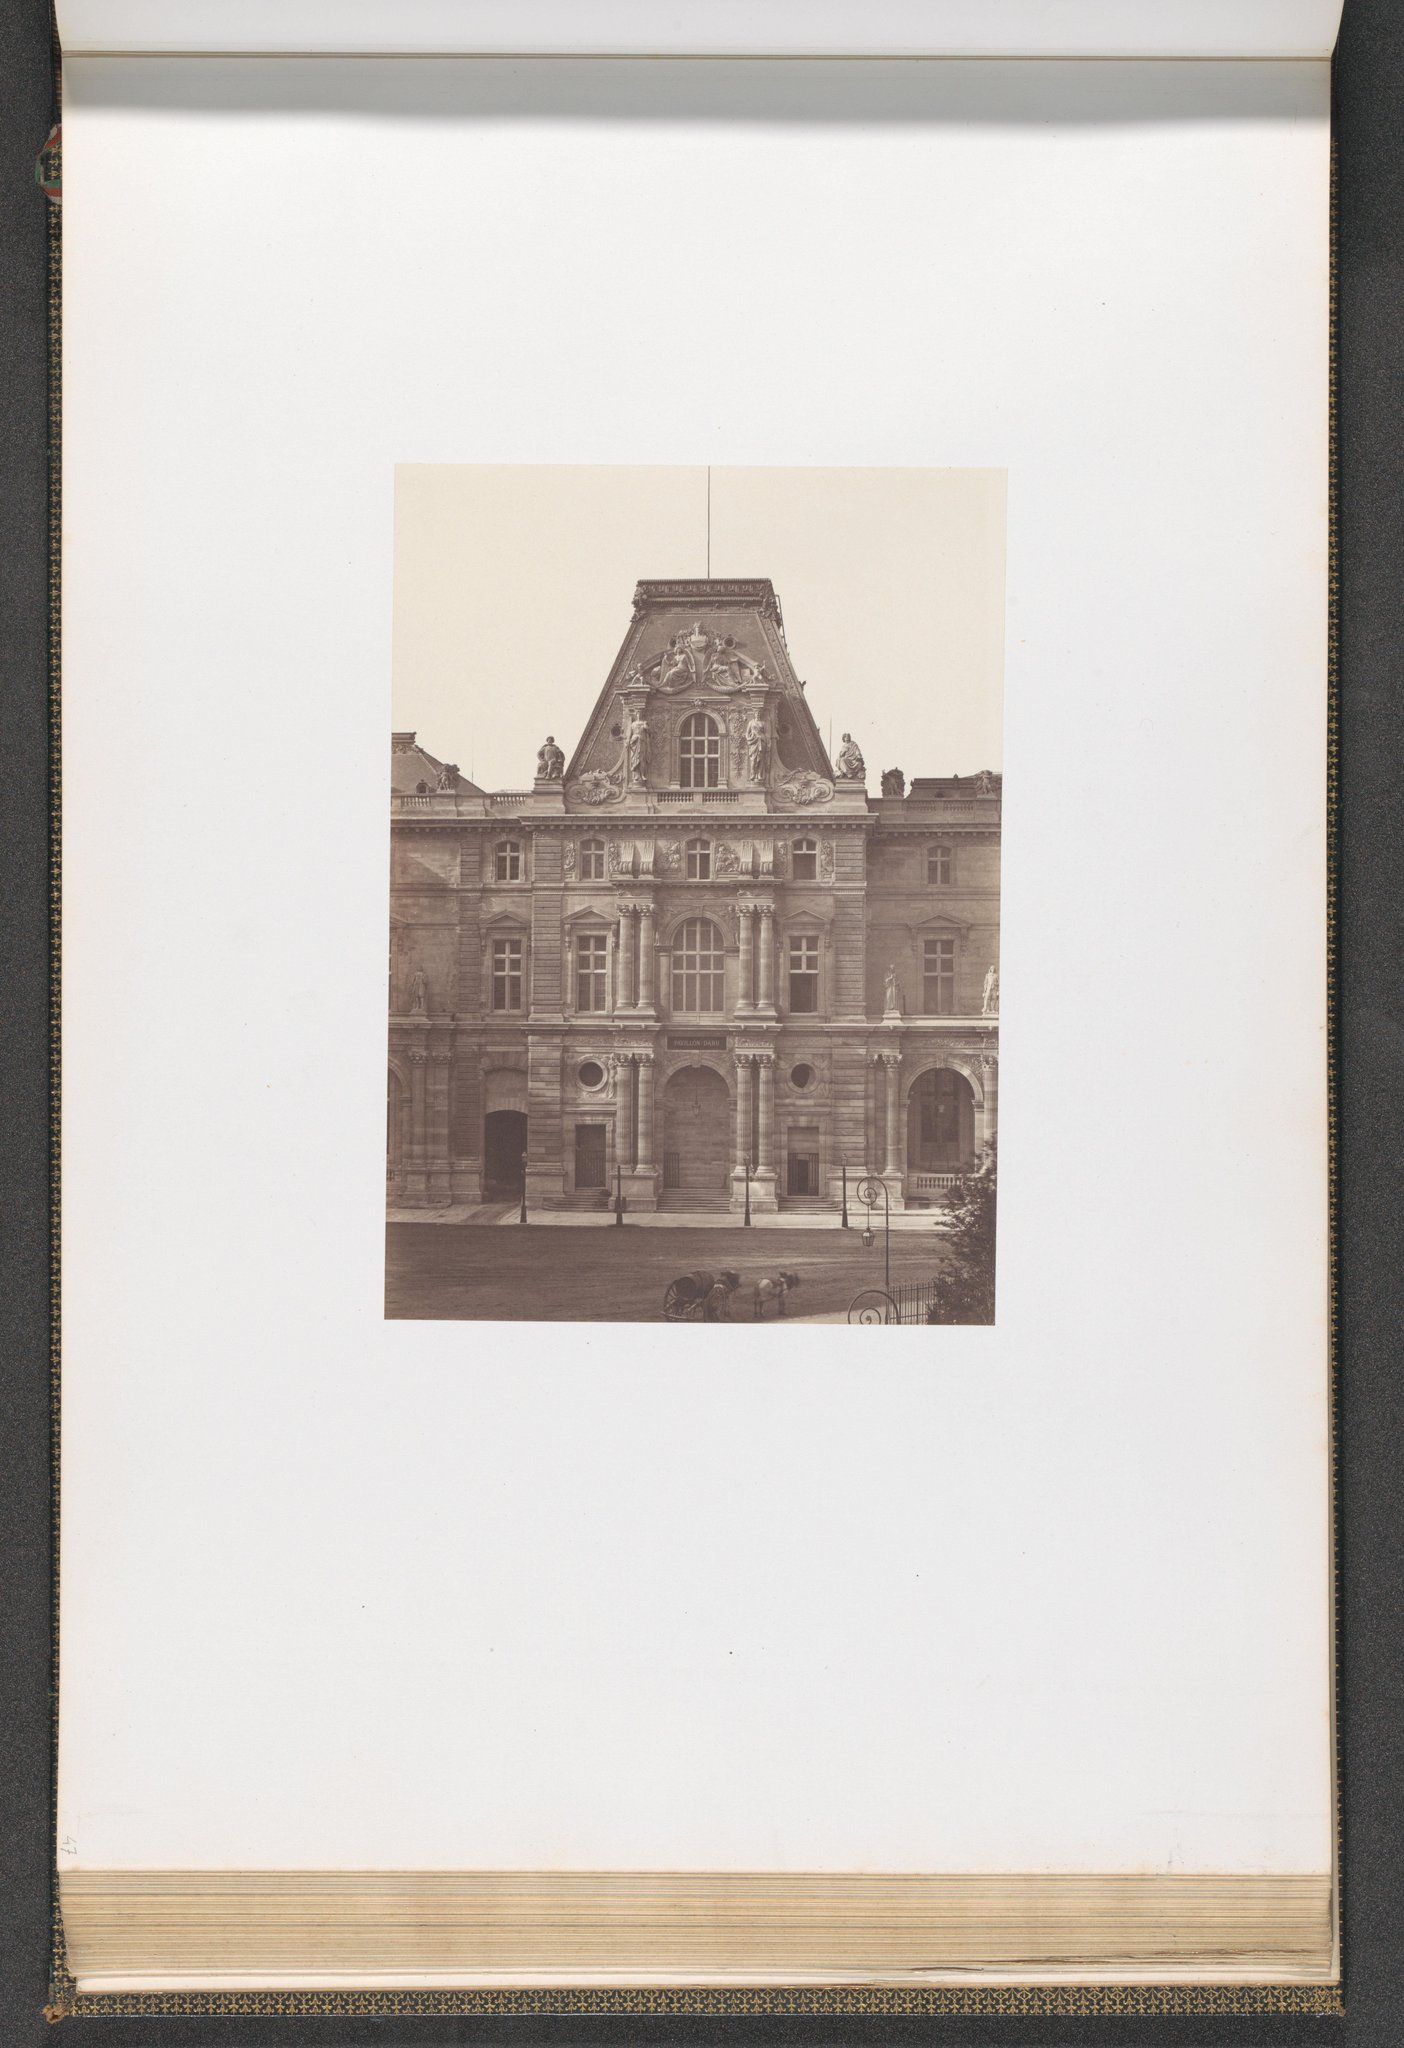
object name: photograph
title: Pavillon Daru in het Palais du Louvre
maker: édouard denis baldus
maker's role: fotograaf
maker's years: 1813-1889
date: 1857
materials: paper, photographic support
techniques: salted paper print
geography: paris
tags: gate, entrance, permanent exhibition, museum, façade (of house or building), paris, tuileries palace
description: Onderdeel van Réunion des Tuileries au Louvre 1852-1857, album 2.